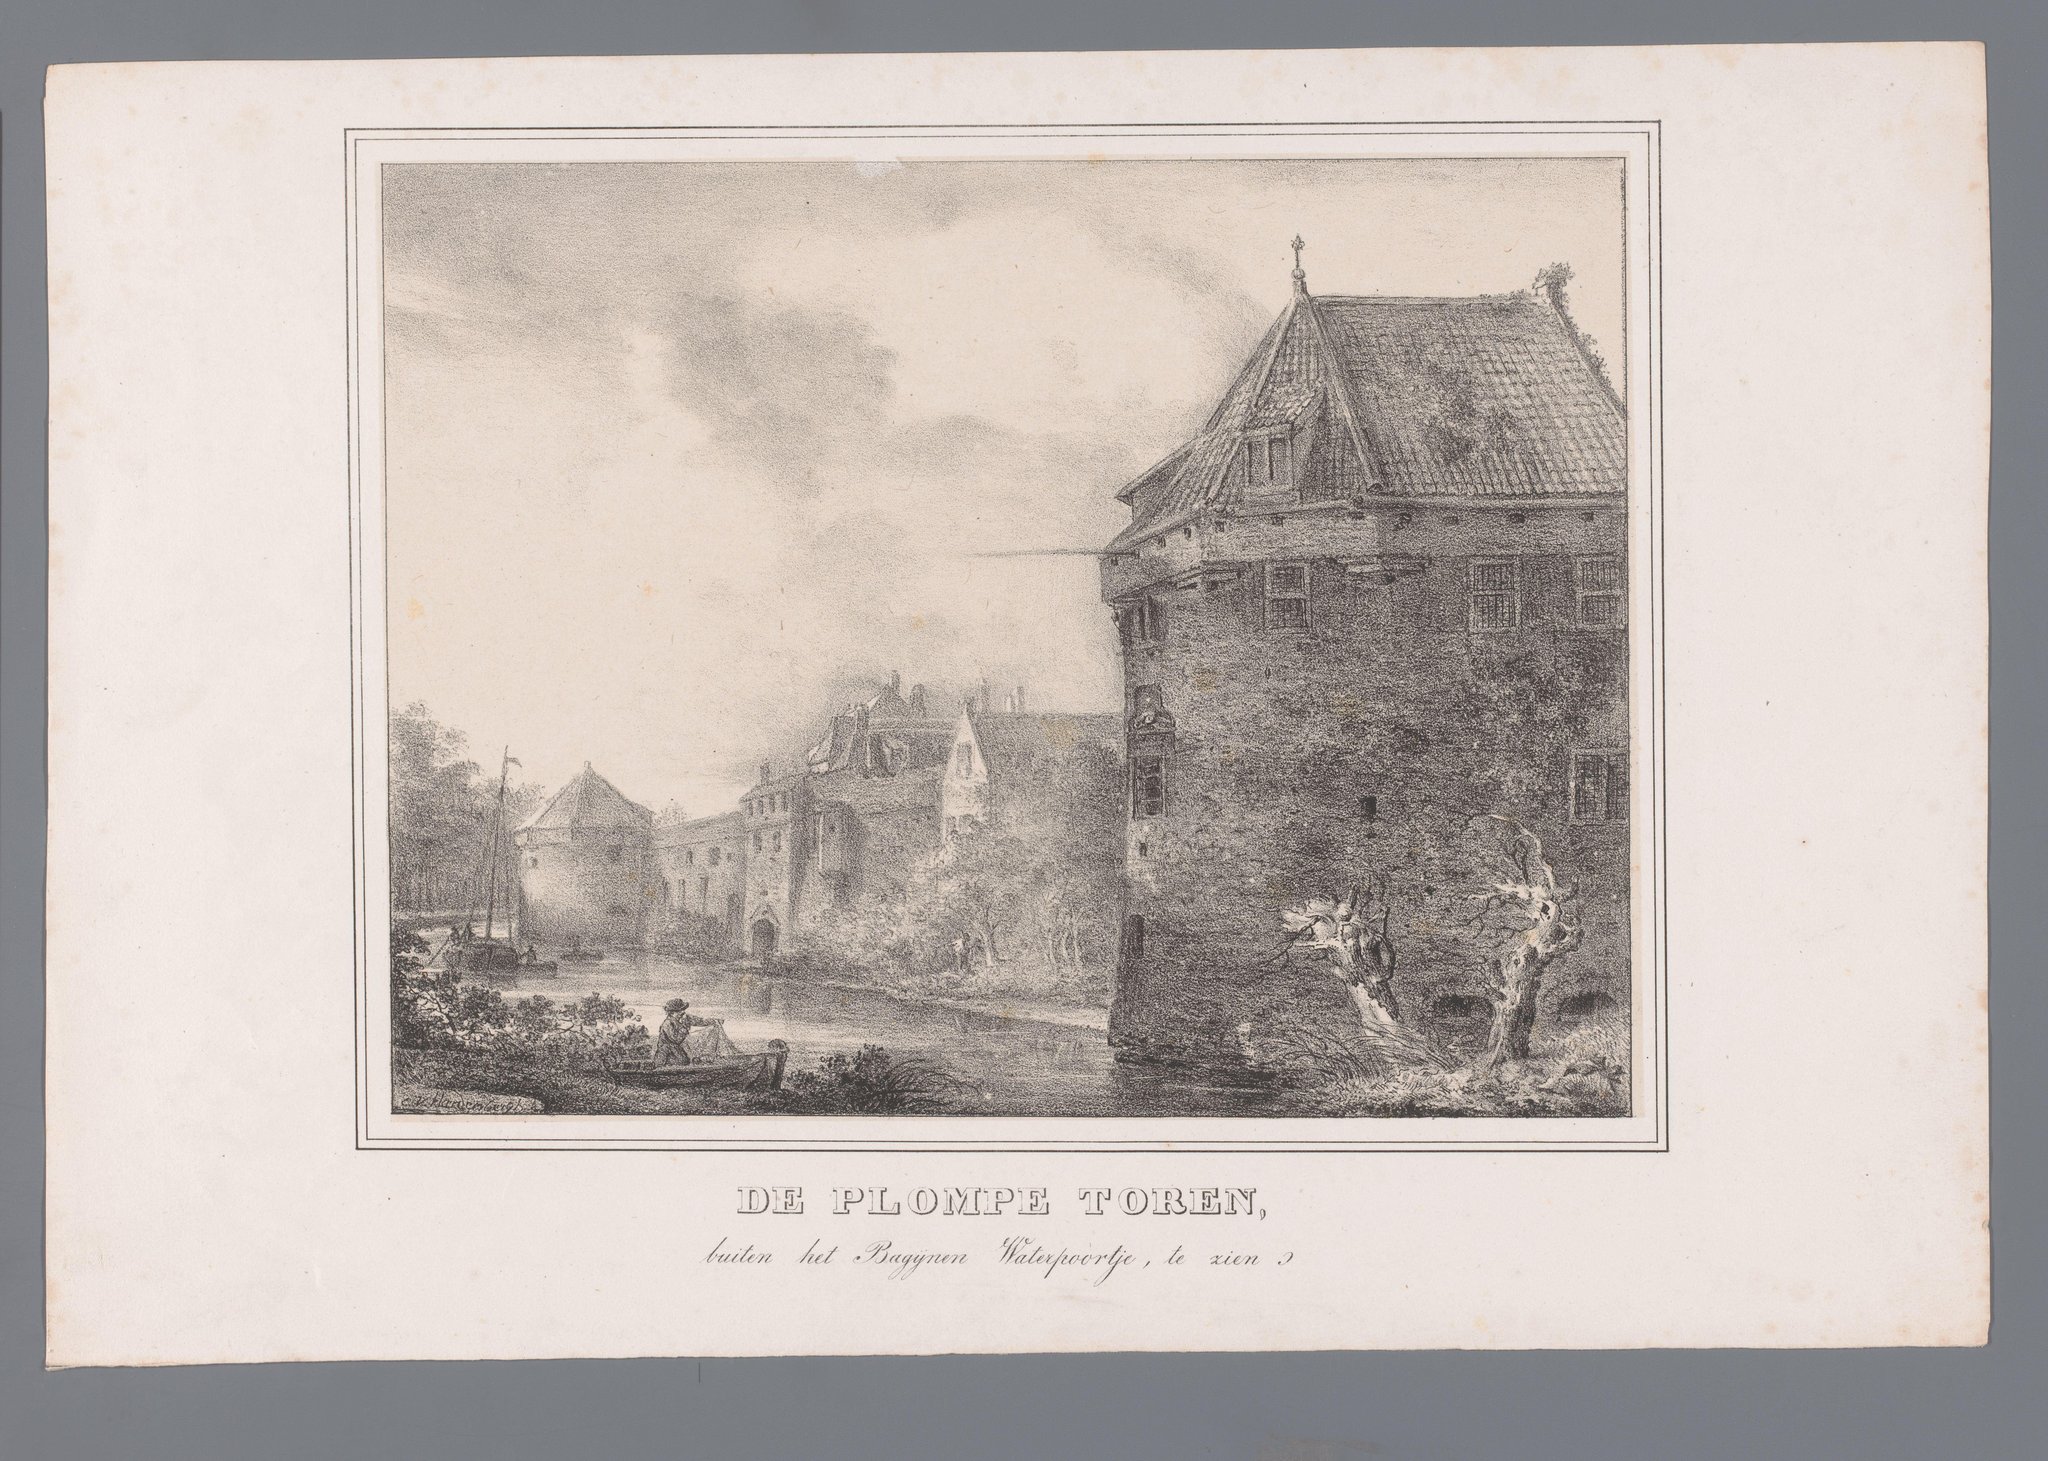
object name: print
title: Afbeeldingen van gezichten te of bij Utrecht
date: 1809-1843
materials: paper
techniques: lithograph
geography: utrecht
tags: towers ~ fortified city, fisherman, utrecht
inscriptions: collector's mark: Lugt 2228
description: Links van de toren loopt een gracht. Een visser is in de weer met zijn netten. Maakt deel uit van een omslag met vijftien prenten. Maakt deel uit van een omslag met vijftien prenten.